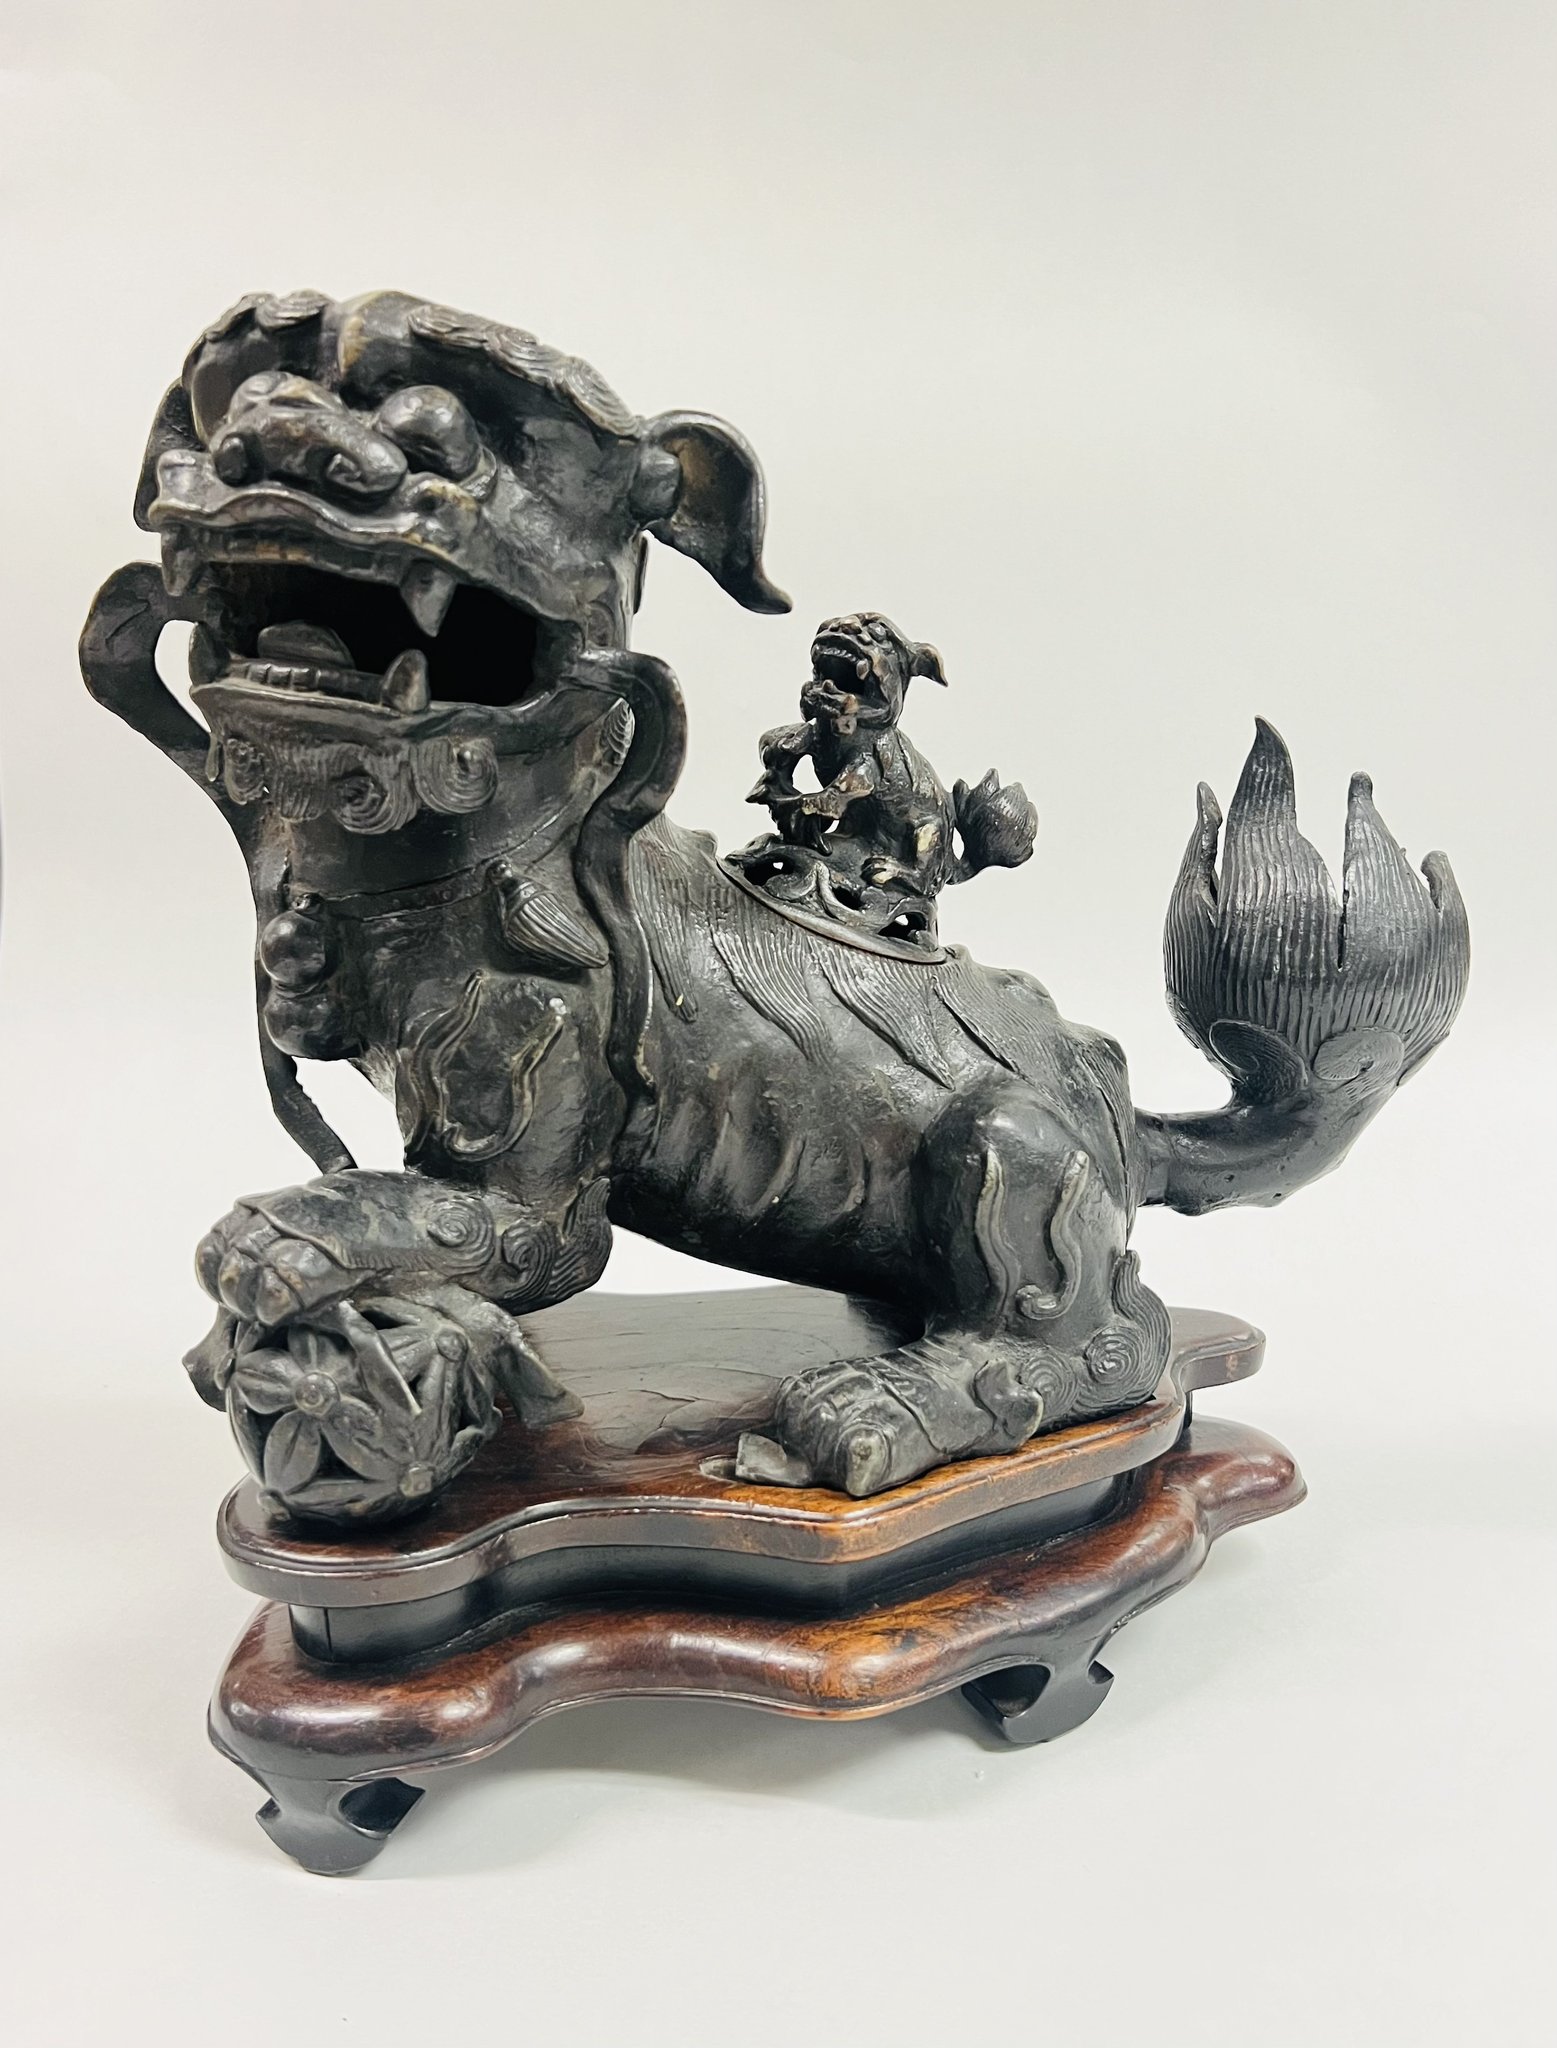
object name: wine vessel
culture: chinese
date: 1701-1800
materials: bronze